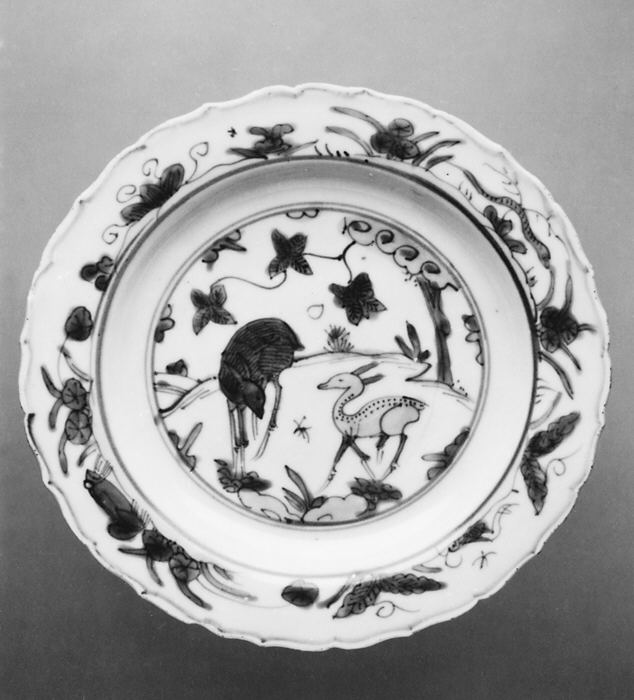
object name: plate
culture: chinese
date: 1368-1644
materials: porcelain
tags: animals